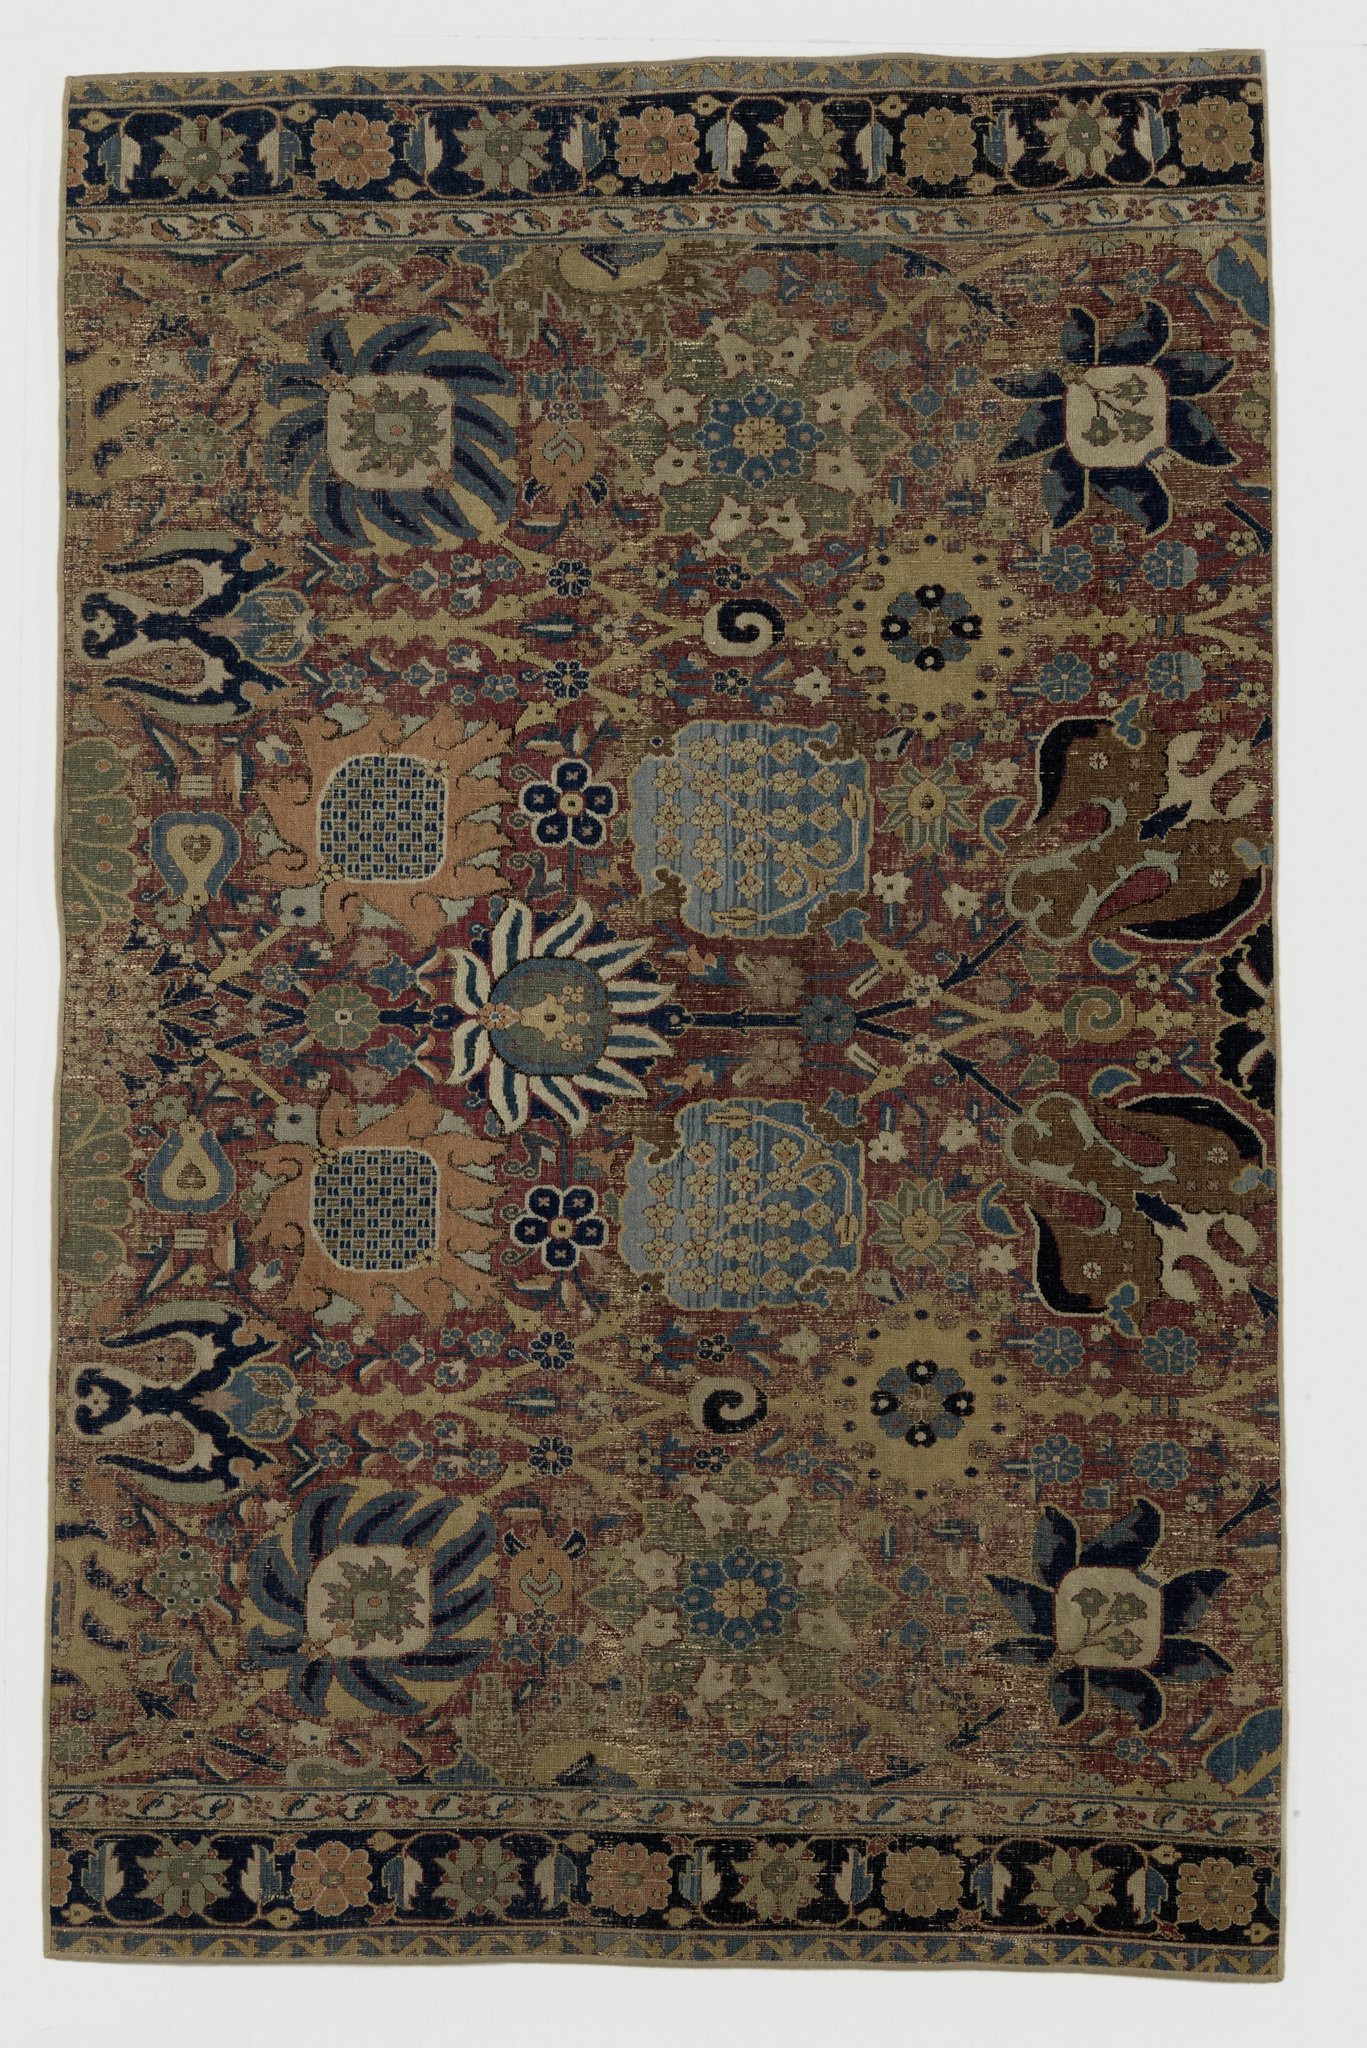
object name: fragment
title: Fragment van een Oosters tapijt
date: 1550-1600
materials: wool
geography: kerman